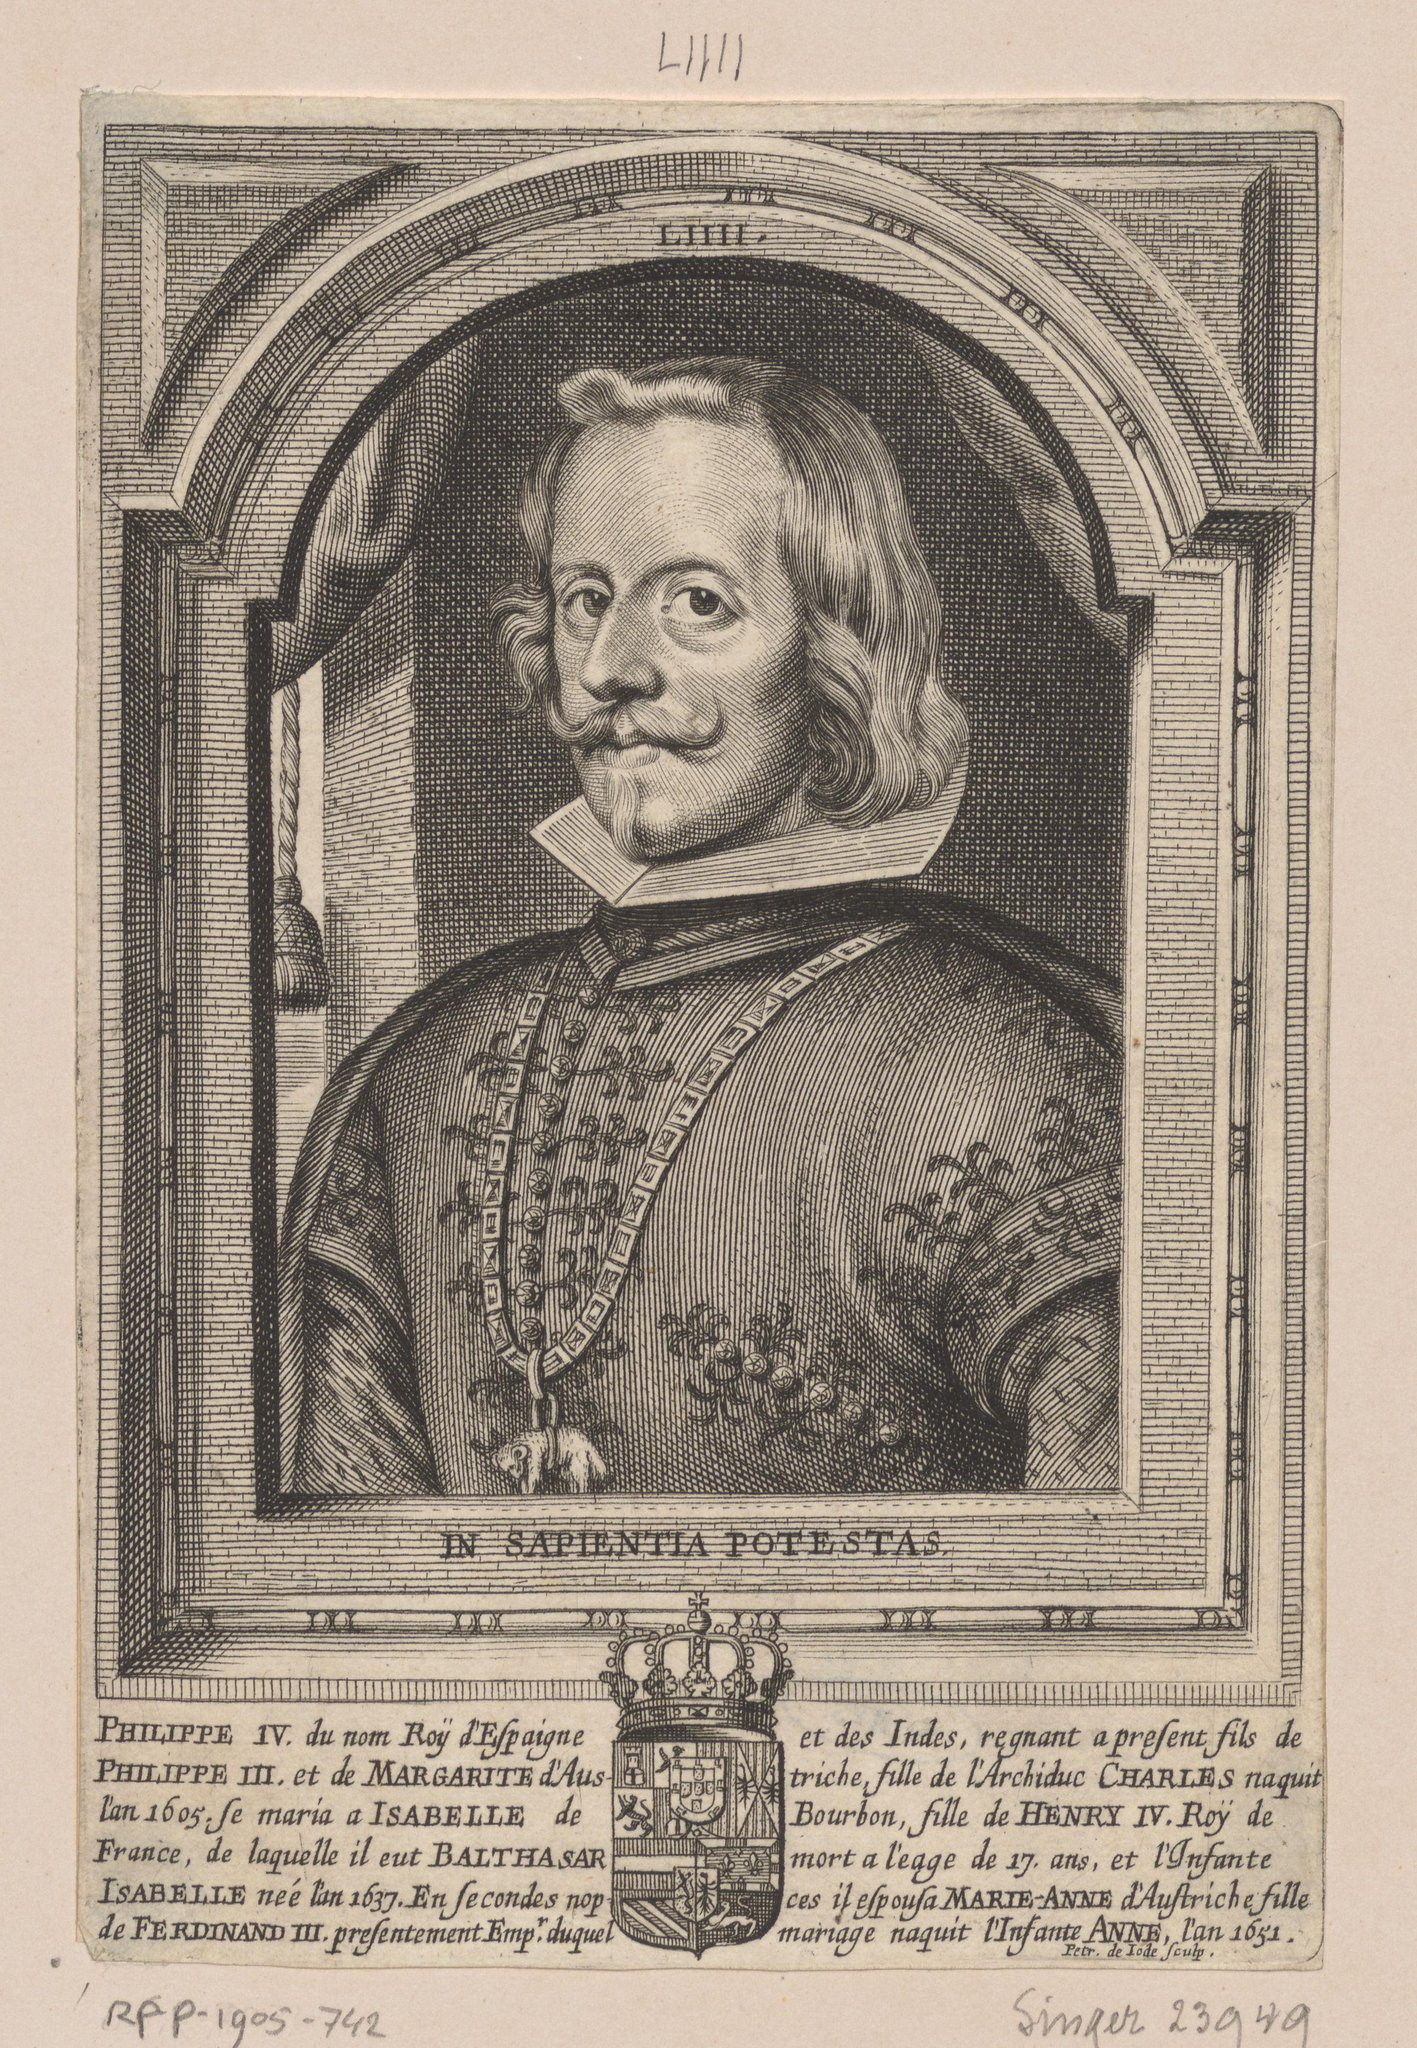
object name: print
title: Portret van Filips IV, koning van Spanje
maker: pieter de jode (ii)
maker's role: draughtsman, print maker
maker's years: 1606-1674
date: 1663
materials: paper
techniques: engraving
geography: antwerp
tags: filips iv (koning van spanje), adult man, historical persons, knighthood order of the golden fleece, armorial bearing, heraldry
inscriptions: collector's mark: Lugt 2228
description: Prent waarschijnlijk uit: Joannes Meyssens. Les effigies des souverains princes et ducs de Brabant avec leur chronologie, armes et devises. Antwerpen: Joannes Meyssens, [1663]. Andere staat met midden boven het nummer LIII is ook gebruikt in een uitgave van bovengenoemde publicatie.